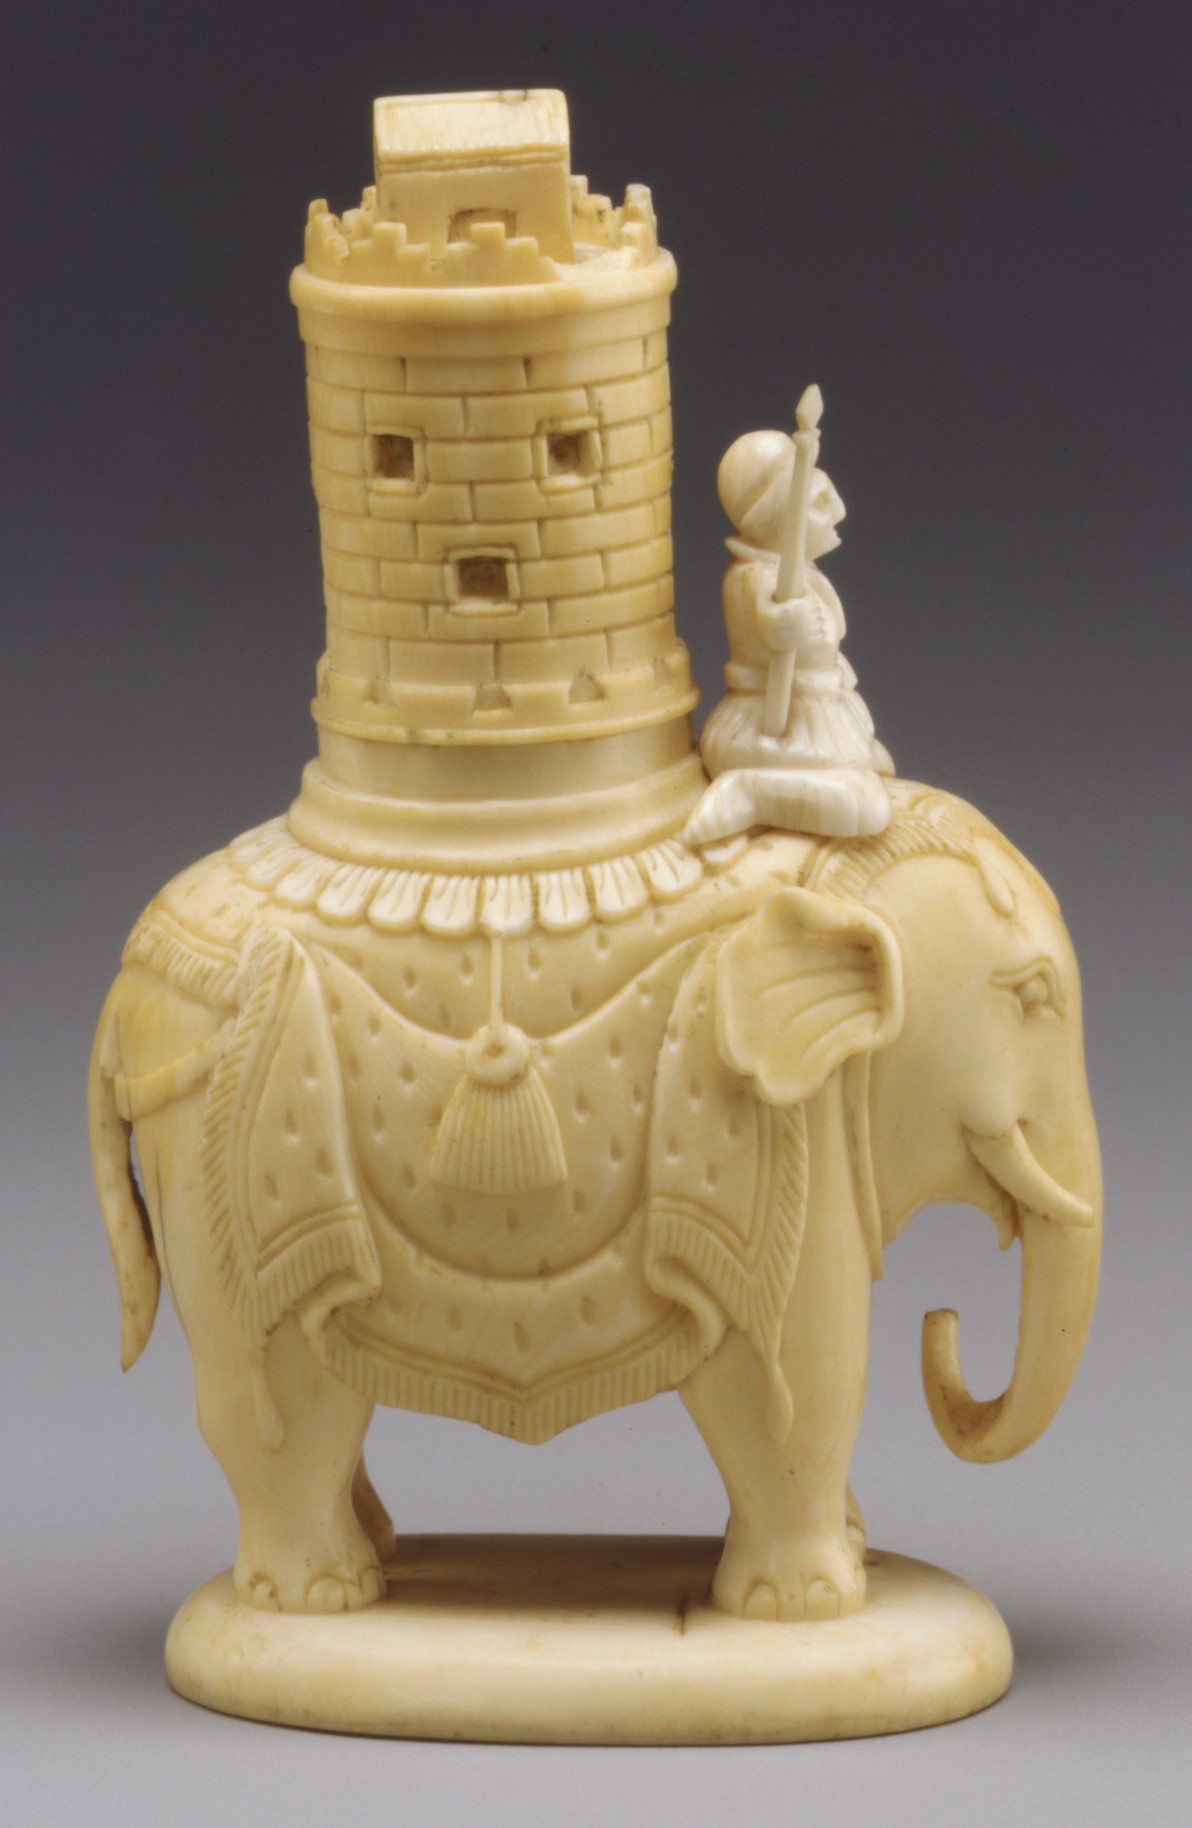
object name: chessman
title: Chessmen (32)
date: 1801-1900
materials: ivory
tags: men,chess,elephants,games